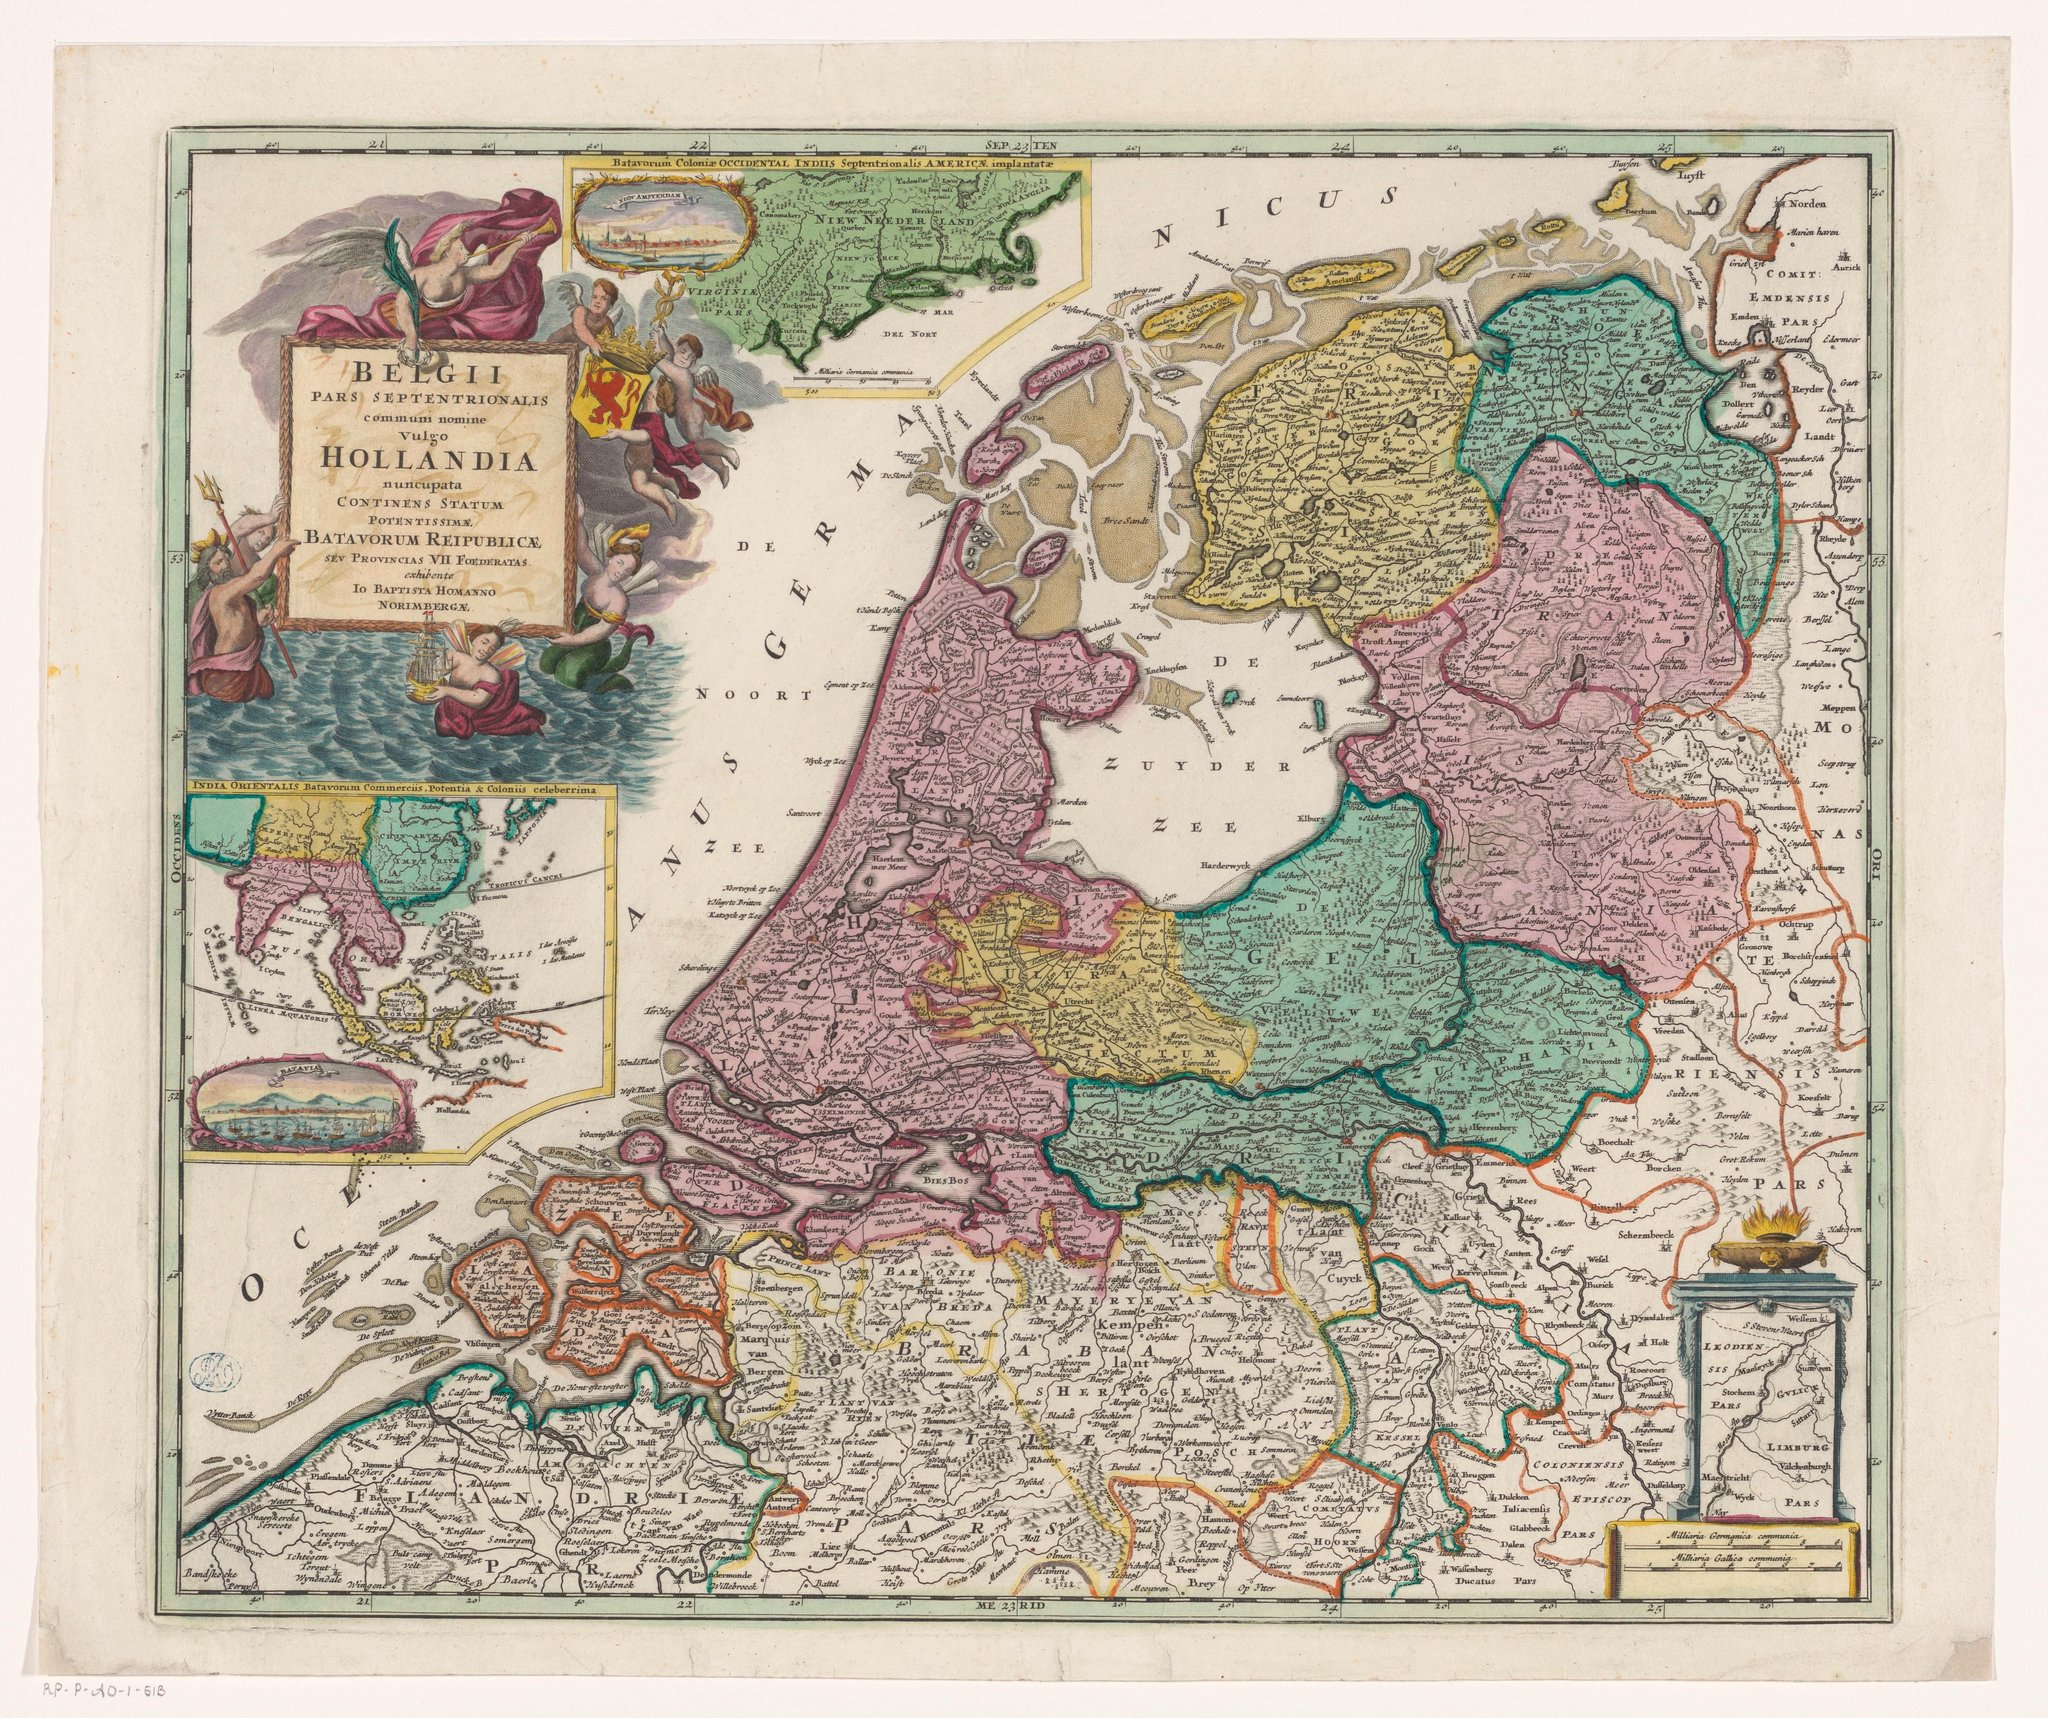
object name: map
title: Belgii pars septentrionalis communi nomine vulgo Hollandia (...)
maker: johann baptista homann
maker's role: print maker, publisher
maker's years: 1664-1724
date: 1707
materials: paper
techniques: engraving, etching, hand coloring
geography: nuremberg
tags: (story of) neptune (poseidon), coat of arms (as symbol of the state, etc.), maps of separate countries or regions, merman - aa - mermaid, siren, fame; 'fama', 'fama buona', 'fama chiara' (ripa), netherlands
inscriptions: collector's mark: Lugt 2228, collector's mark: Lugt 195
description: Linksboven cartouche met titel, daaromheen zijn verschillende figuren afgebeeld, waaronder: Neptunus, Fama, drie putti die het wapen van de Republiek dragen en twee zeemeerminnen. Rechts van de titelcartouche een inzetkaart van Nieuw Nederland en een ovaal stadsgezicht van Nieuw Amsterdam, bijhorende schaalstok: Milliaria Germanica communia. Onder de titelcartouche een inzetkaart van Oost-Indië en een ovaal stadsgezicht van Batavia. Rechtsonder een inzetkaart van een deel van het huidige Limburg (deel dat destijds tot Staats-Brabant behoorde). Daaronder schaalstok: Milliaria Germanica communia, Milliaria Gallica communia. Gradenverdeling langs de randen.